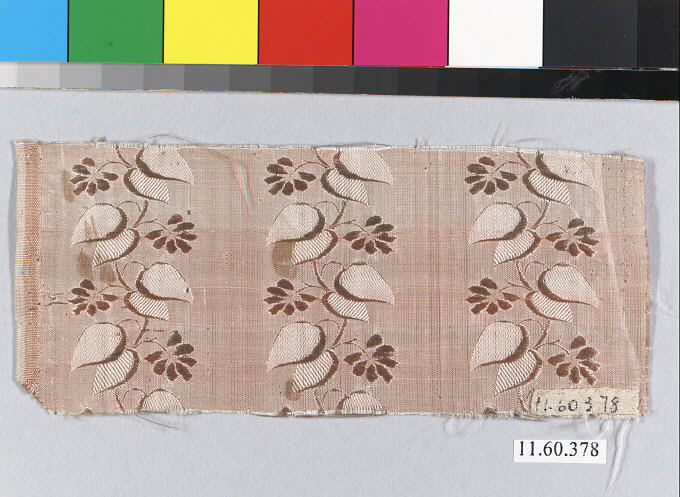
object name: fragment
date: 1801-1900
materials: silk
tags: leaves